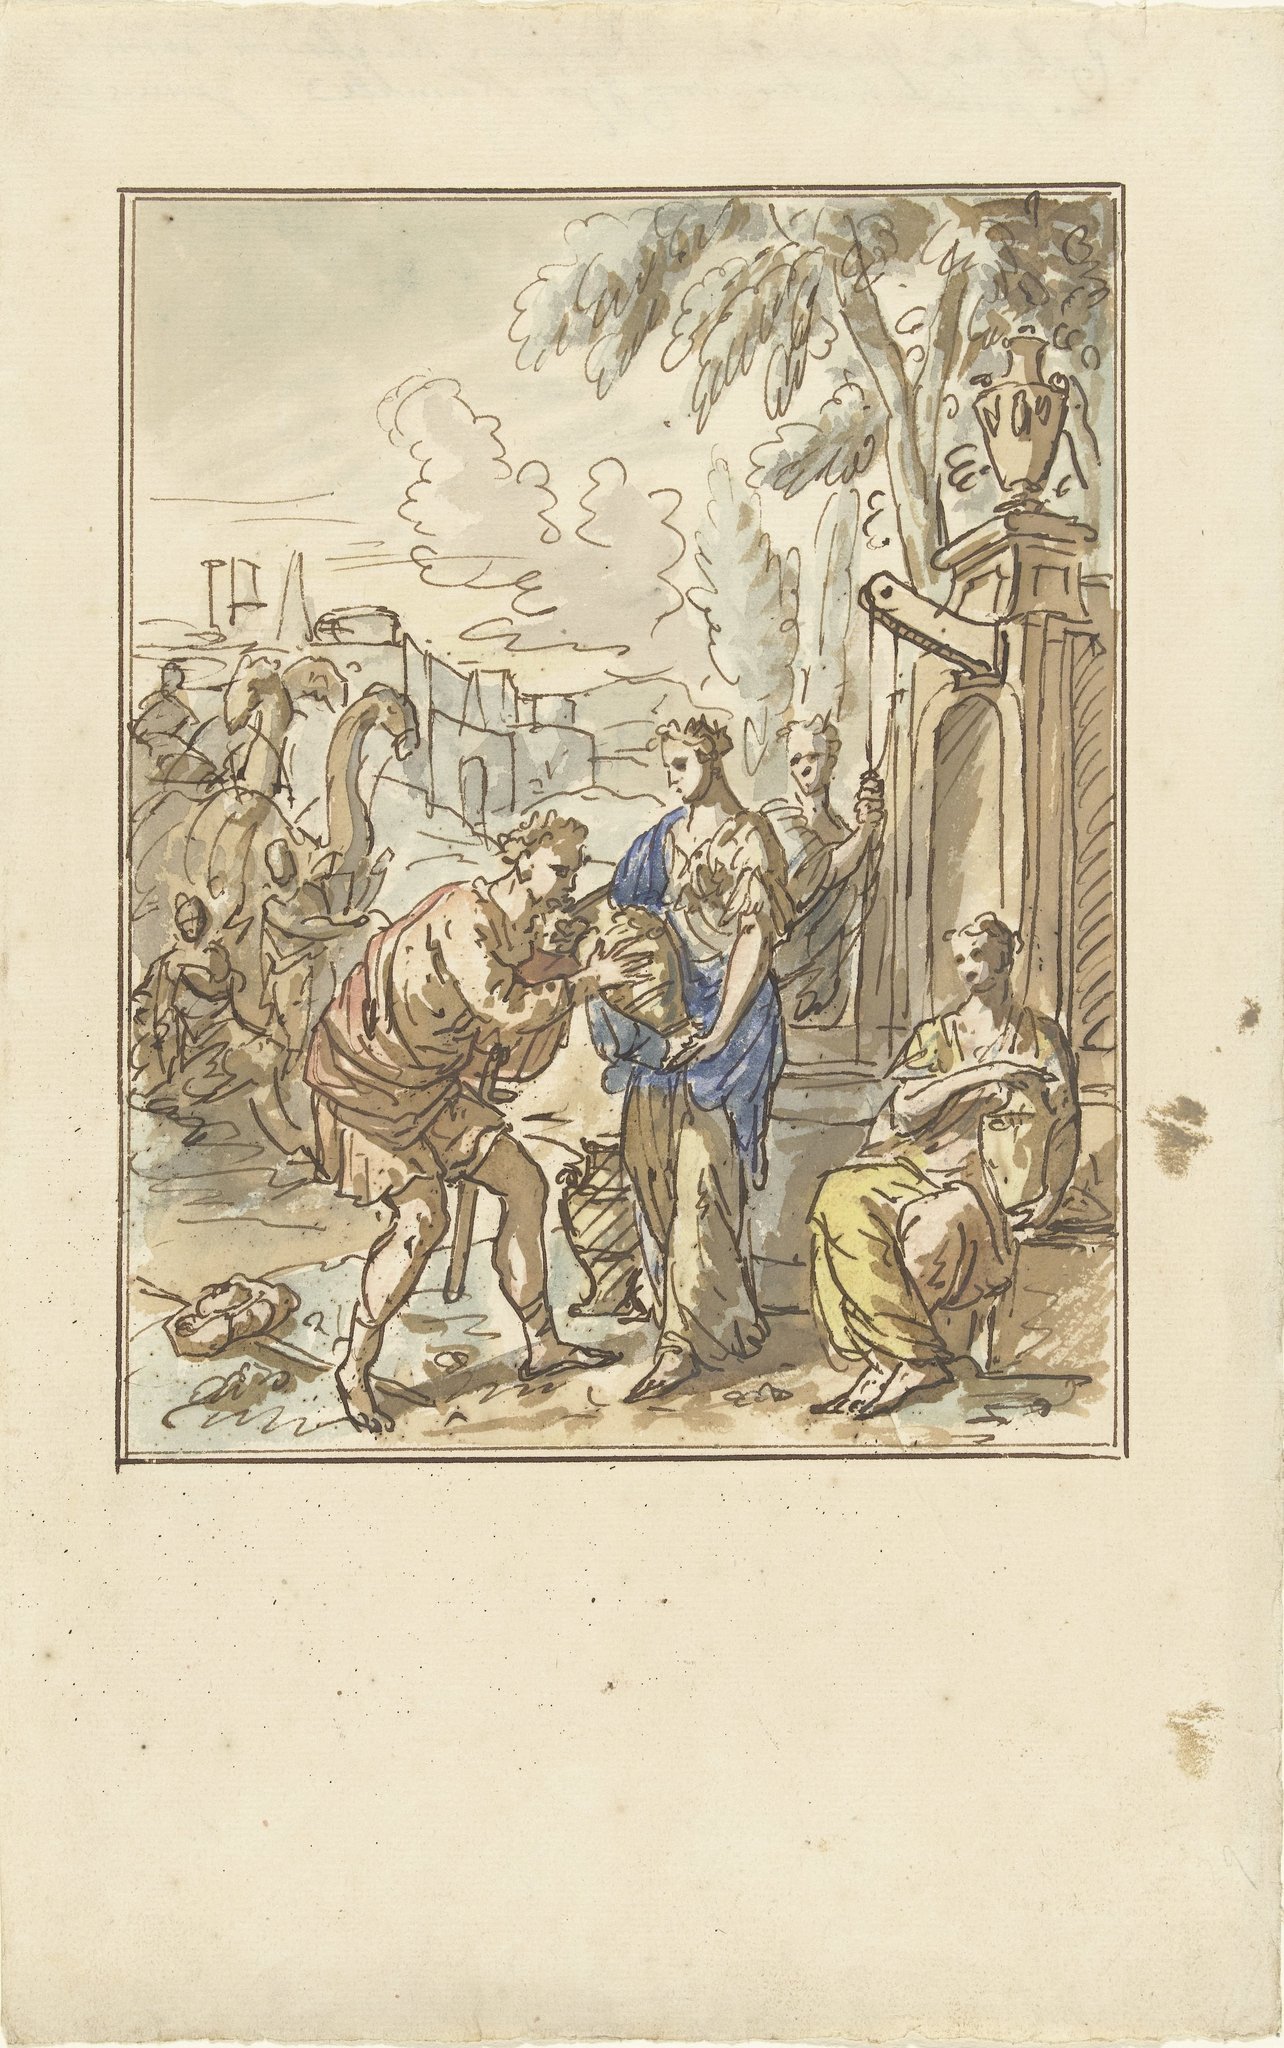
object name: drawing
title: Rebekka geeft Eliëzer te drinken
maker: elias van nijmegen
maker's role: draughtsman, painter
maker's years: 1667-1755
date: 1677-1755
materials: ink, paper, watercolor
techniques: brush, pen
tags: rebekah offers eliezer a drink from her pitcher